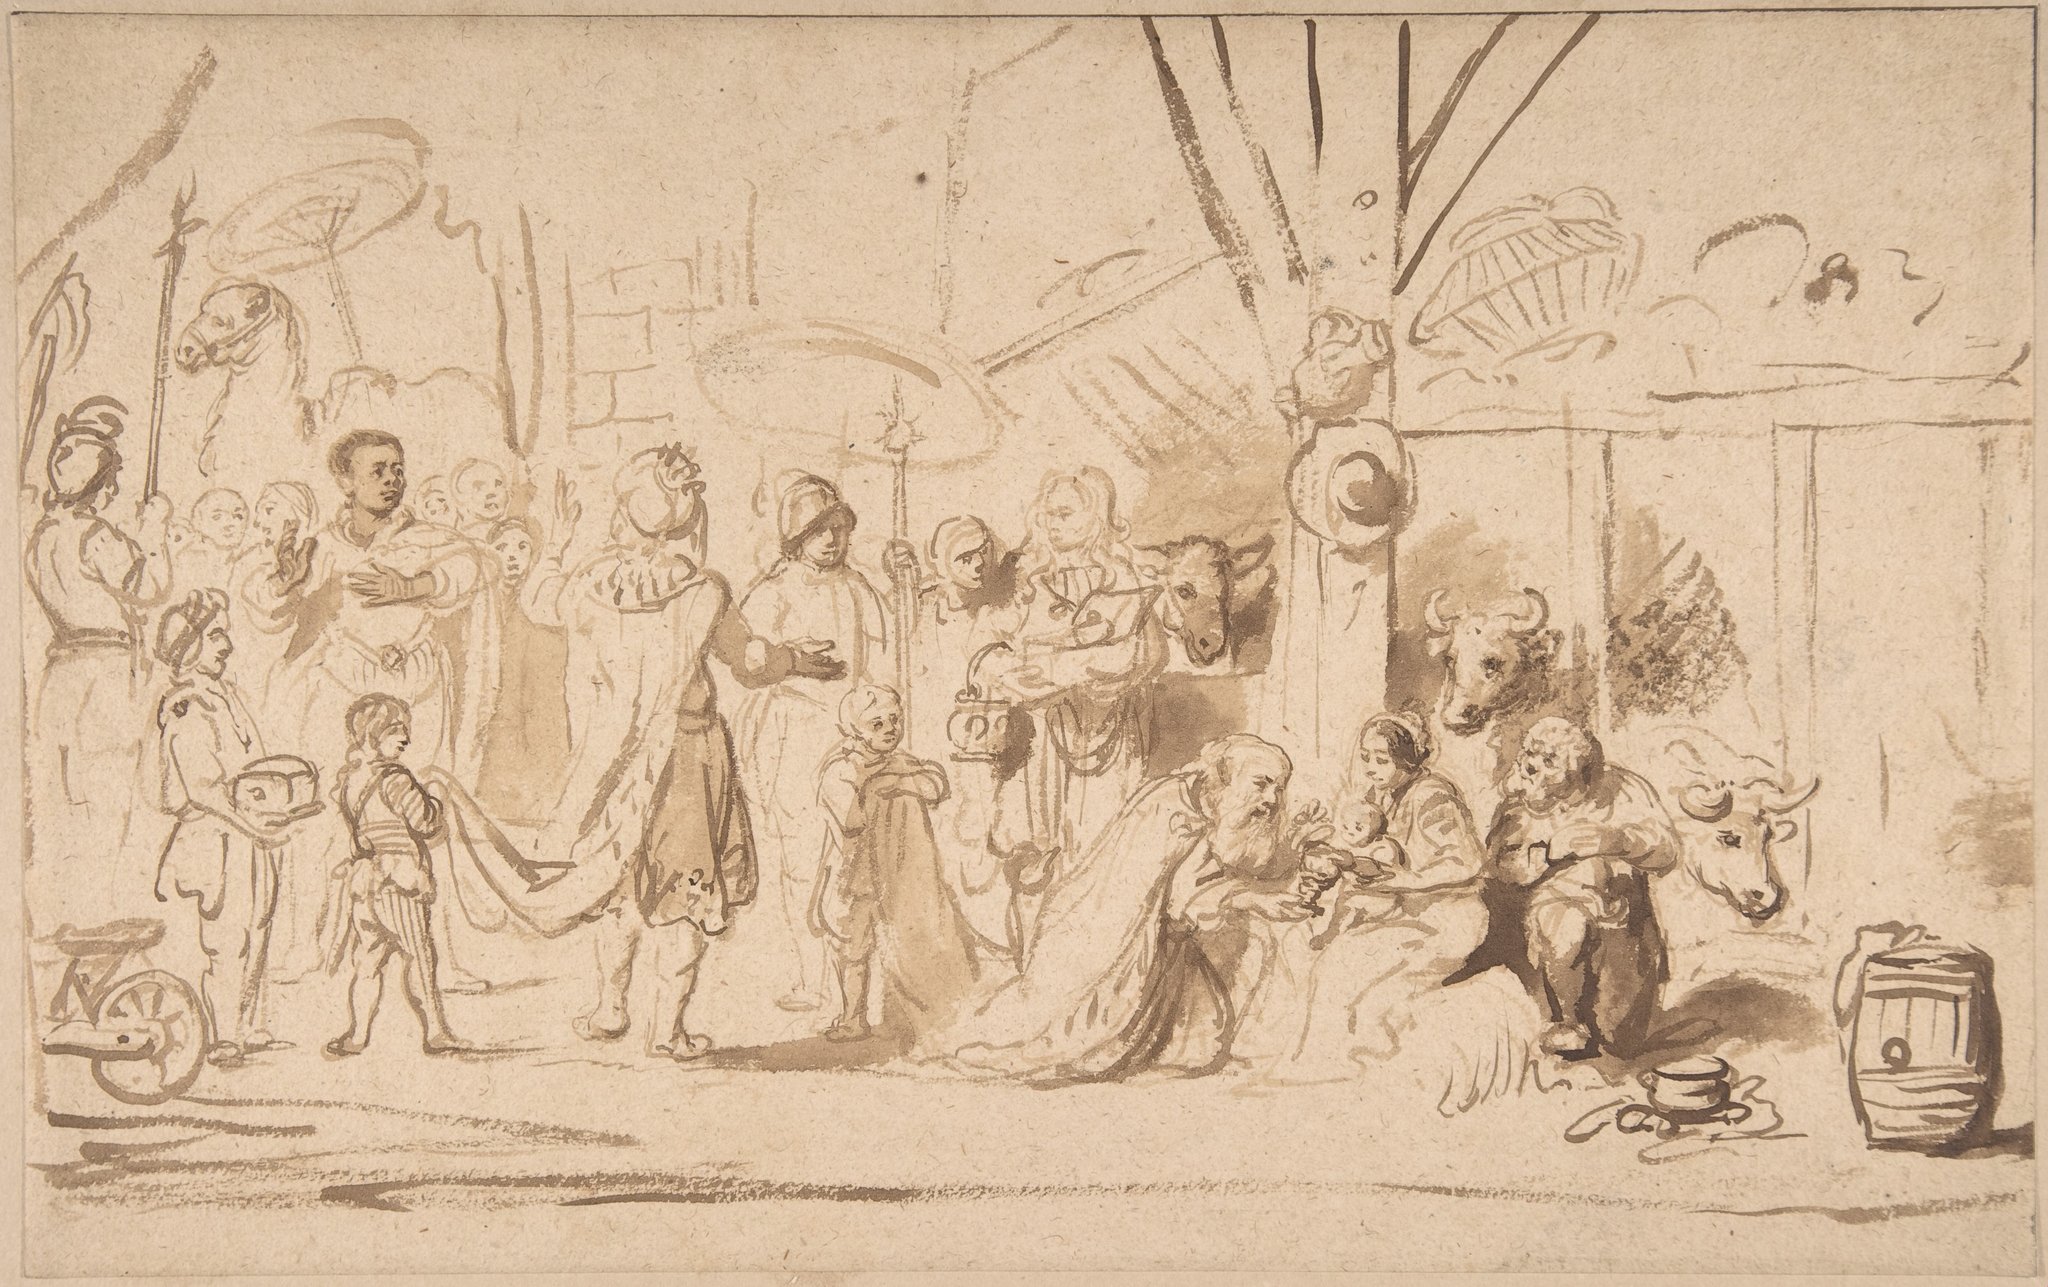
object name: drawing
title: The Adoration of the Magi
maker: nicolaes maes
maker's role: artist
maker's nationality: dutch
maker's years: 1634-1693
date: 1601-1700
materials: ink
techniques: brush, pen, wash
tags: adoration of the magi